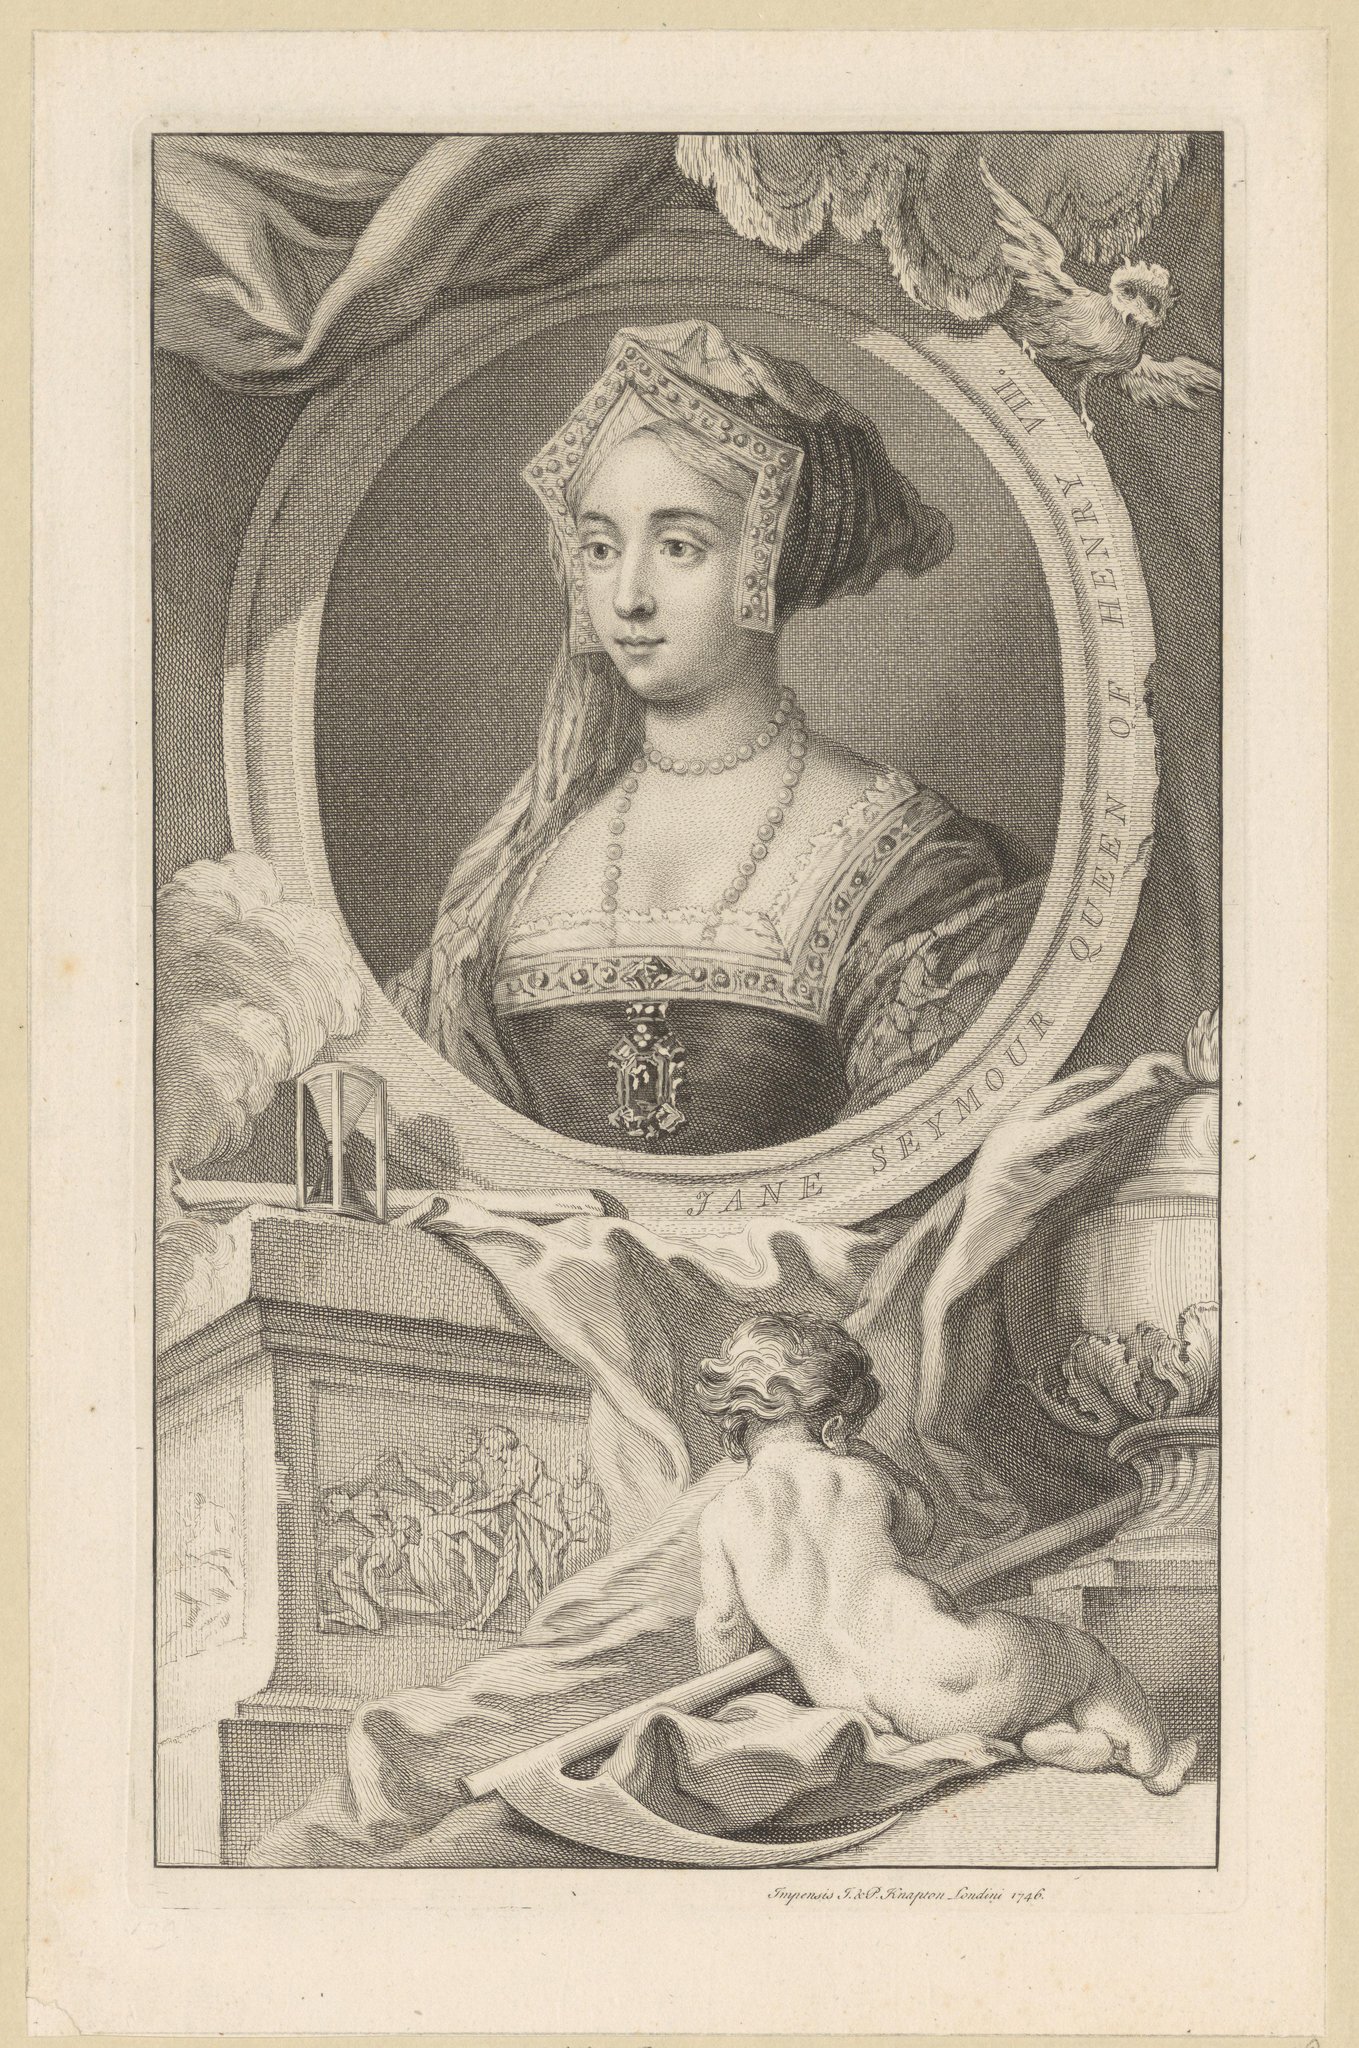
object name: book illustration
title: Portret van Jane Seymour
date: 1746-1747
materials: paper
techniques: engraving, etching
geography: london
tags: historical persons, queen, owls, allegory of time and eternity, cupids: 'amores', 'amoretti', 'putti'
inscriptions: collector's mark: Lugt 2228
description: Prent gebruikt in: Birch, Thomas. The heads of illustrious persons of Great Britain (...). Londen: John & Paul Knapton, 1747, p. 8.